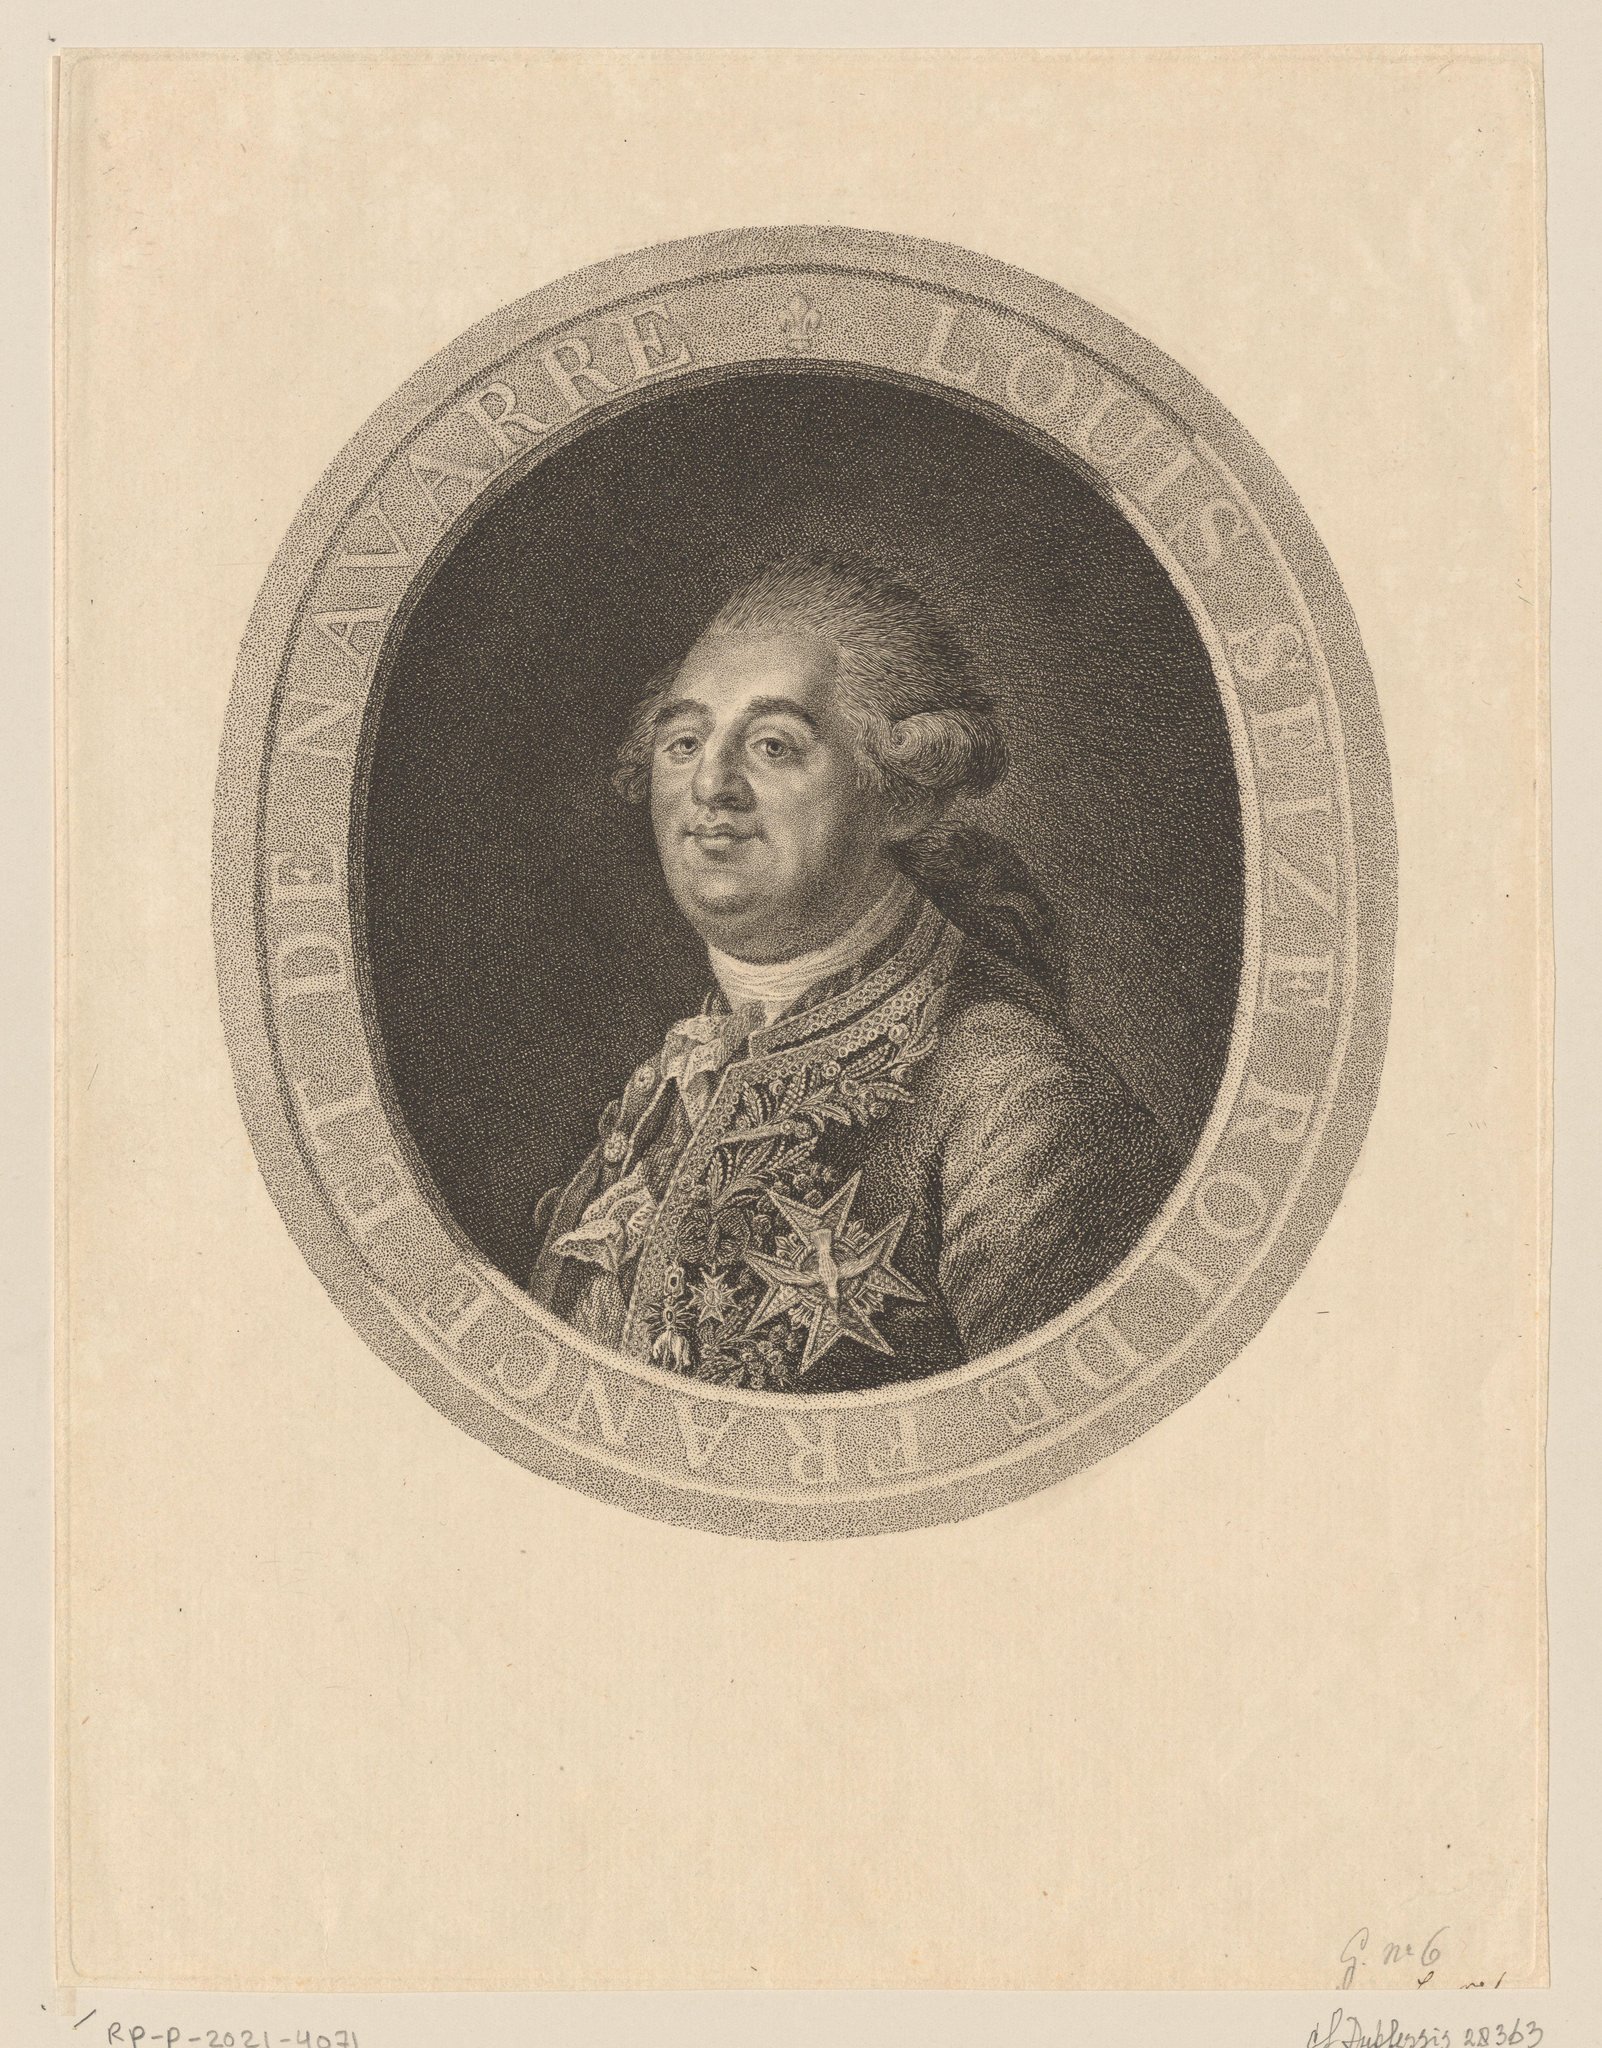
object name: print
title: Portret van Lodewijk XVI van Frankrijk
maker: Anonymous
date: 1784-1799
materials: paper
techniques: etching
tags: lodewijk xvi (koning van frankrijk), ornament ~ medallion, historical persons, wig, knighthood order of the golden fleece - insignia of a knighthood order, e.g.: badge, chain (with name of order), king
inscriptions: inscription: ‘G. nr 6’